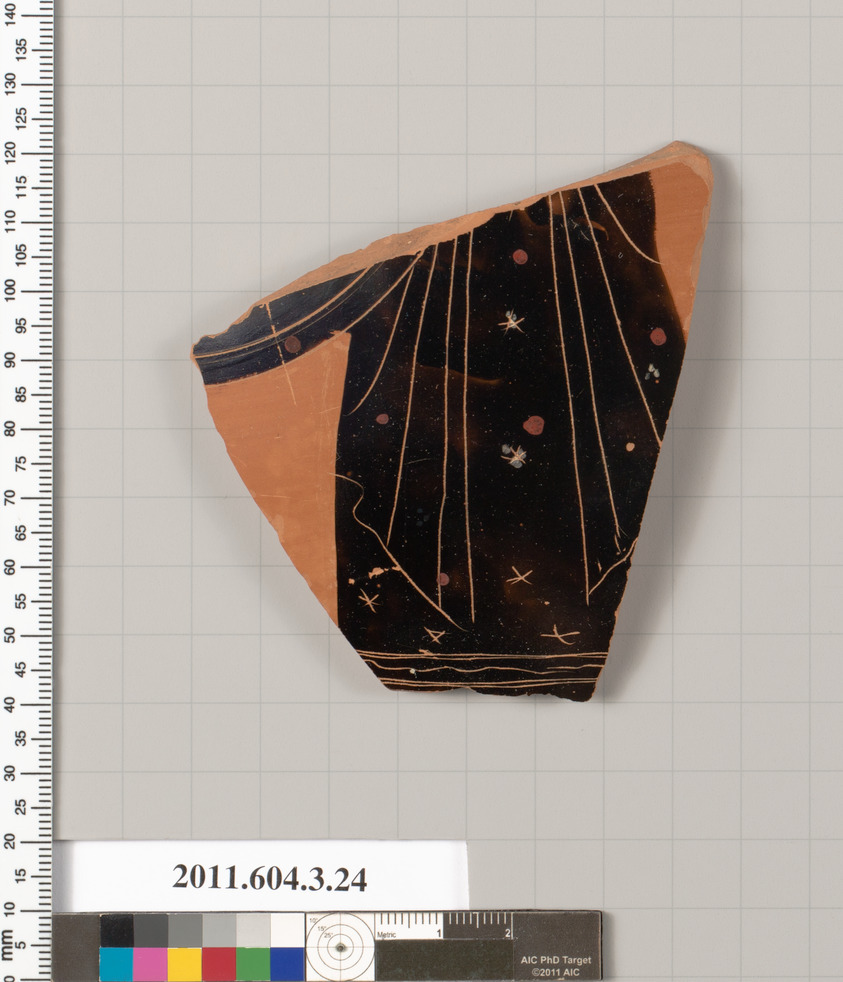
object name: neck amphora fragment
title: Terracotta fragment of a neck-amphora (jar)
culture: greek, attic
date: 550-525 BCE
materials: terracotta